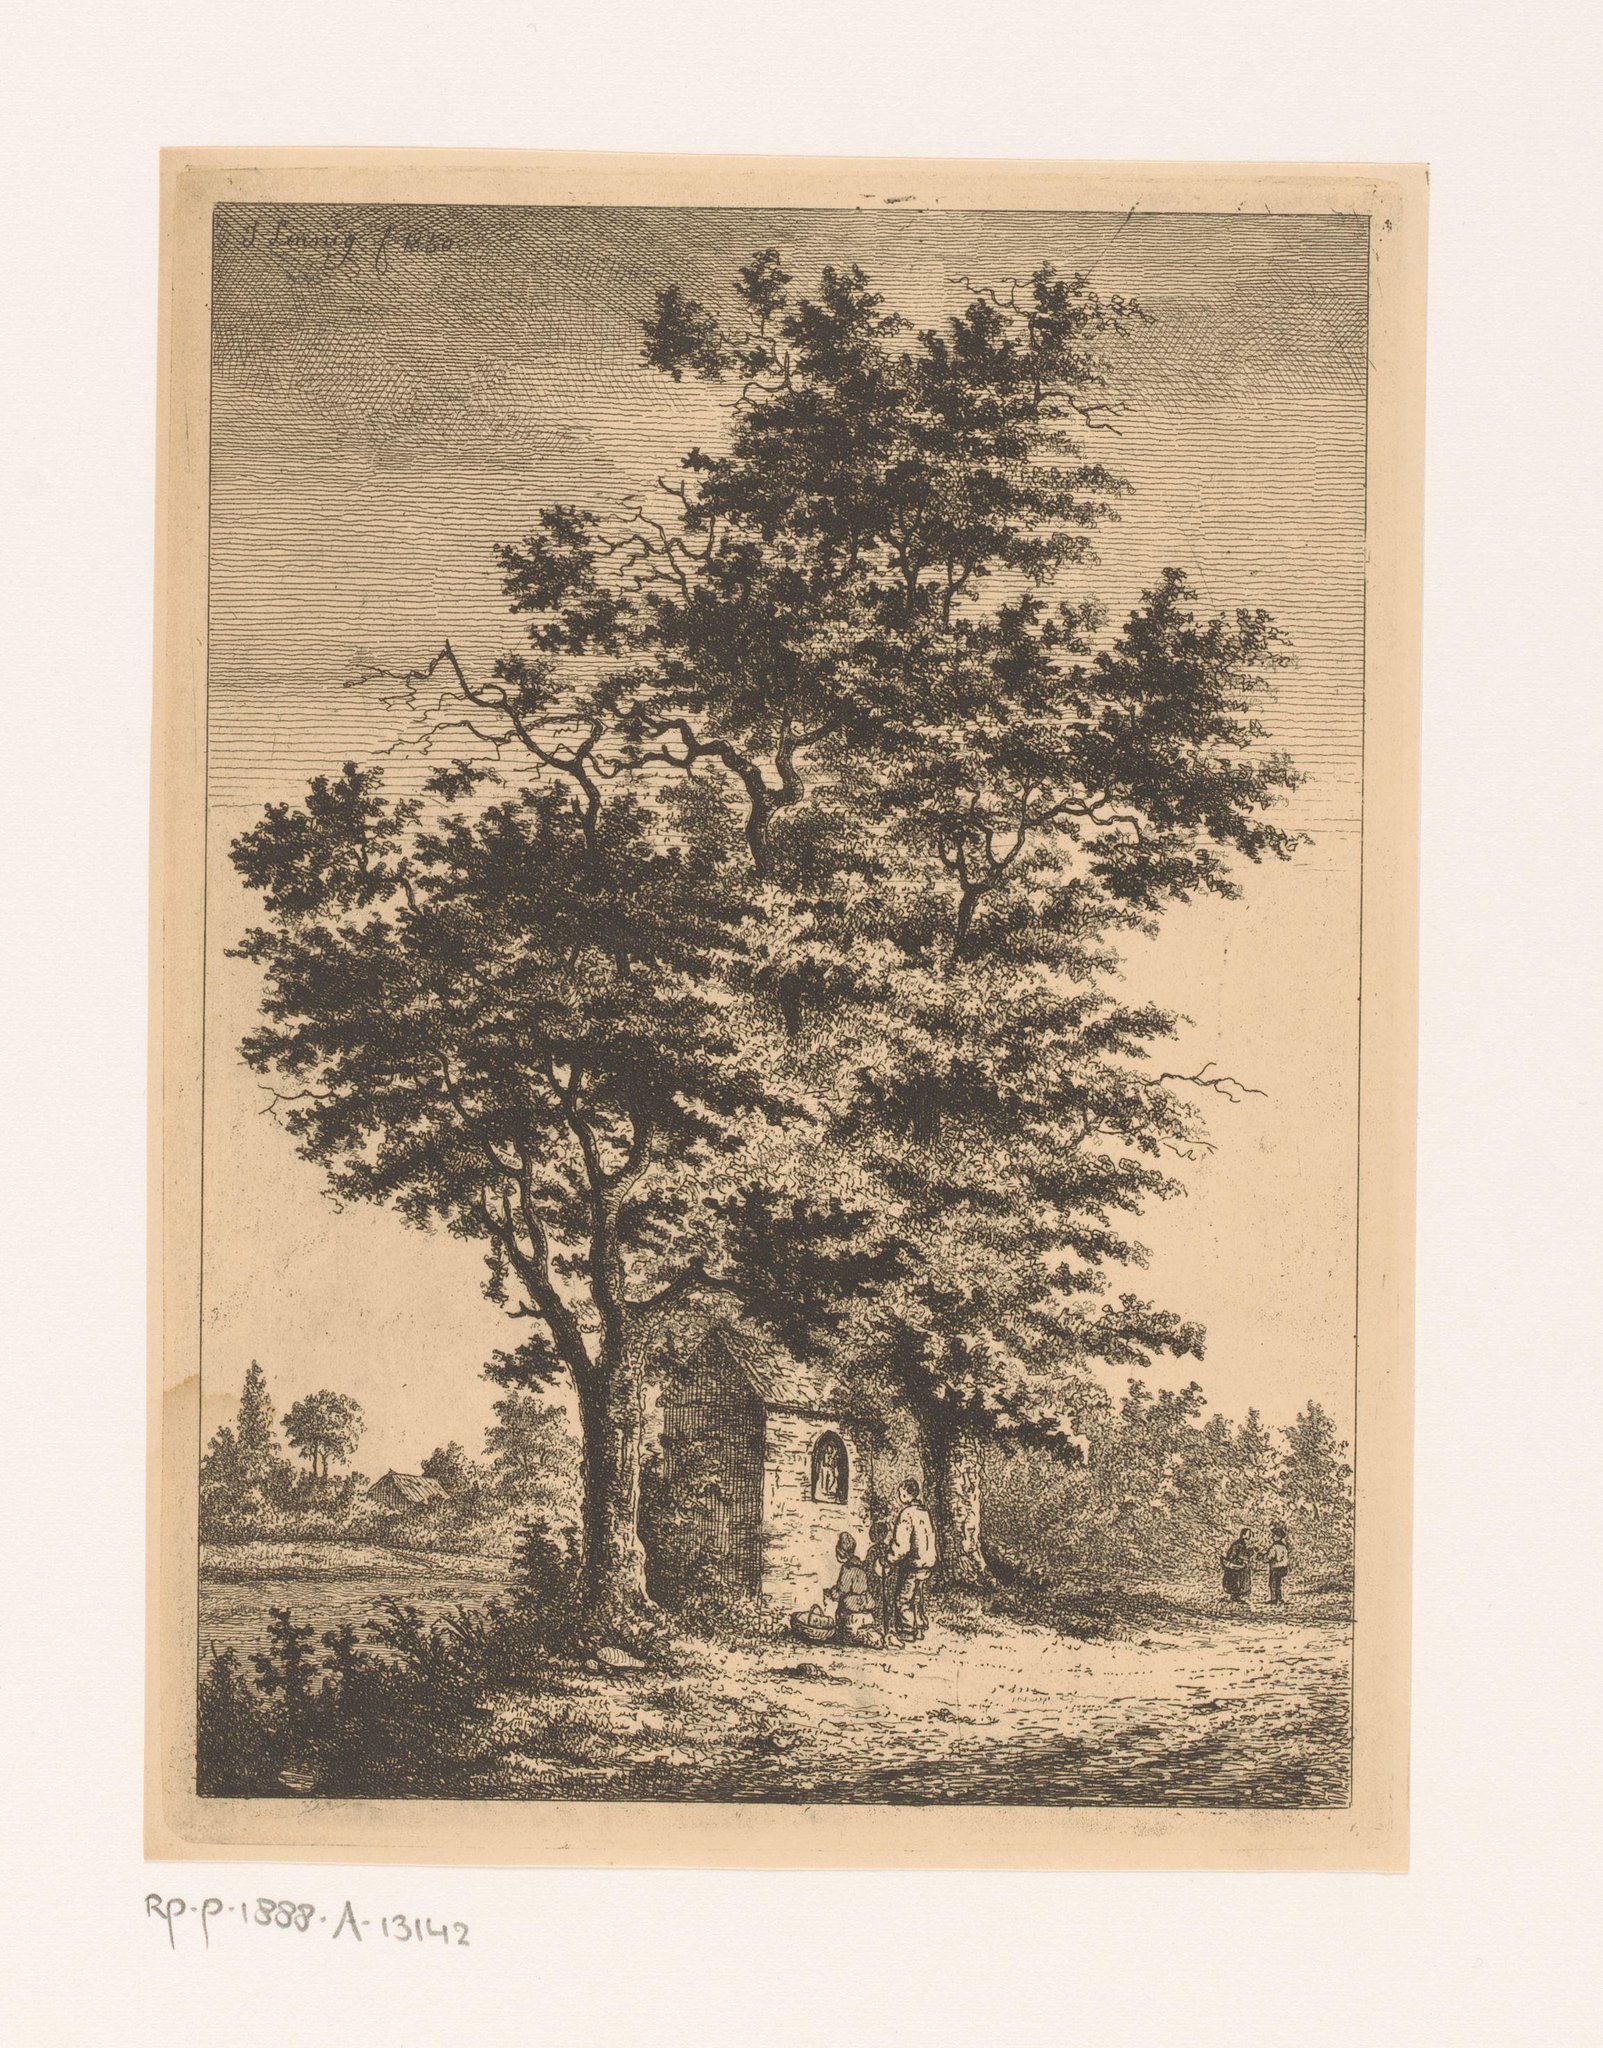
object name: print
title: Landschap met kapel bij Beert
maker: jean théodore joseph linnig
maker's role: draughtsman, print maker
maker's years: 1815-1891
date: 1850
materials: paper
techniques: etching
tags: church (exterior) - qq - small church, chapel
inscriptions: collector's mark: Lugt 2228